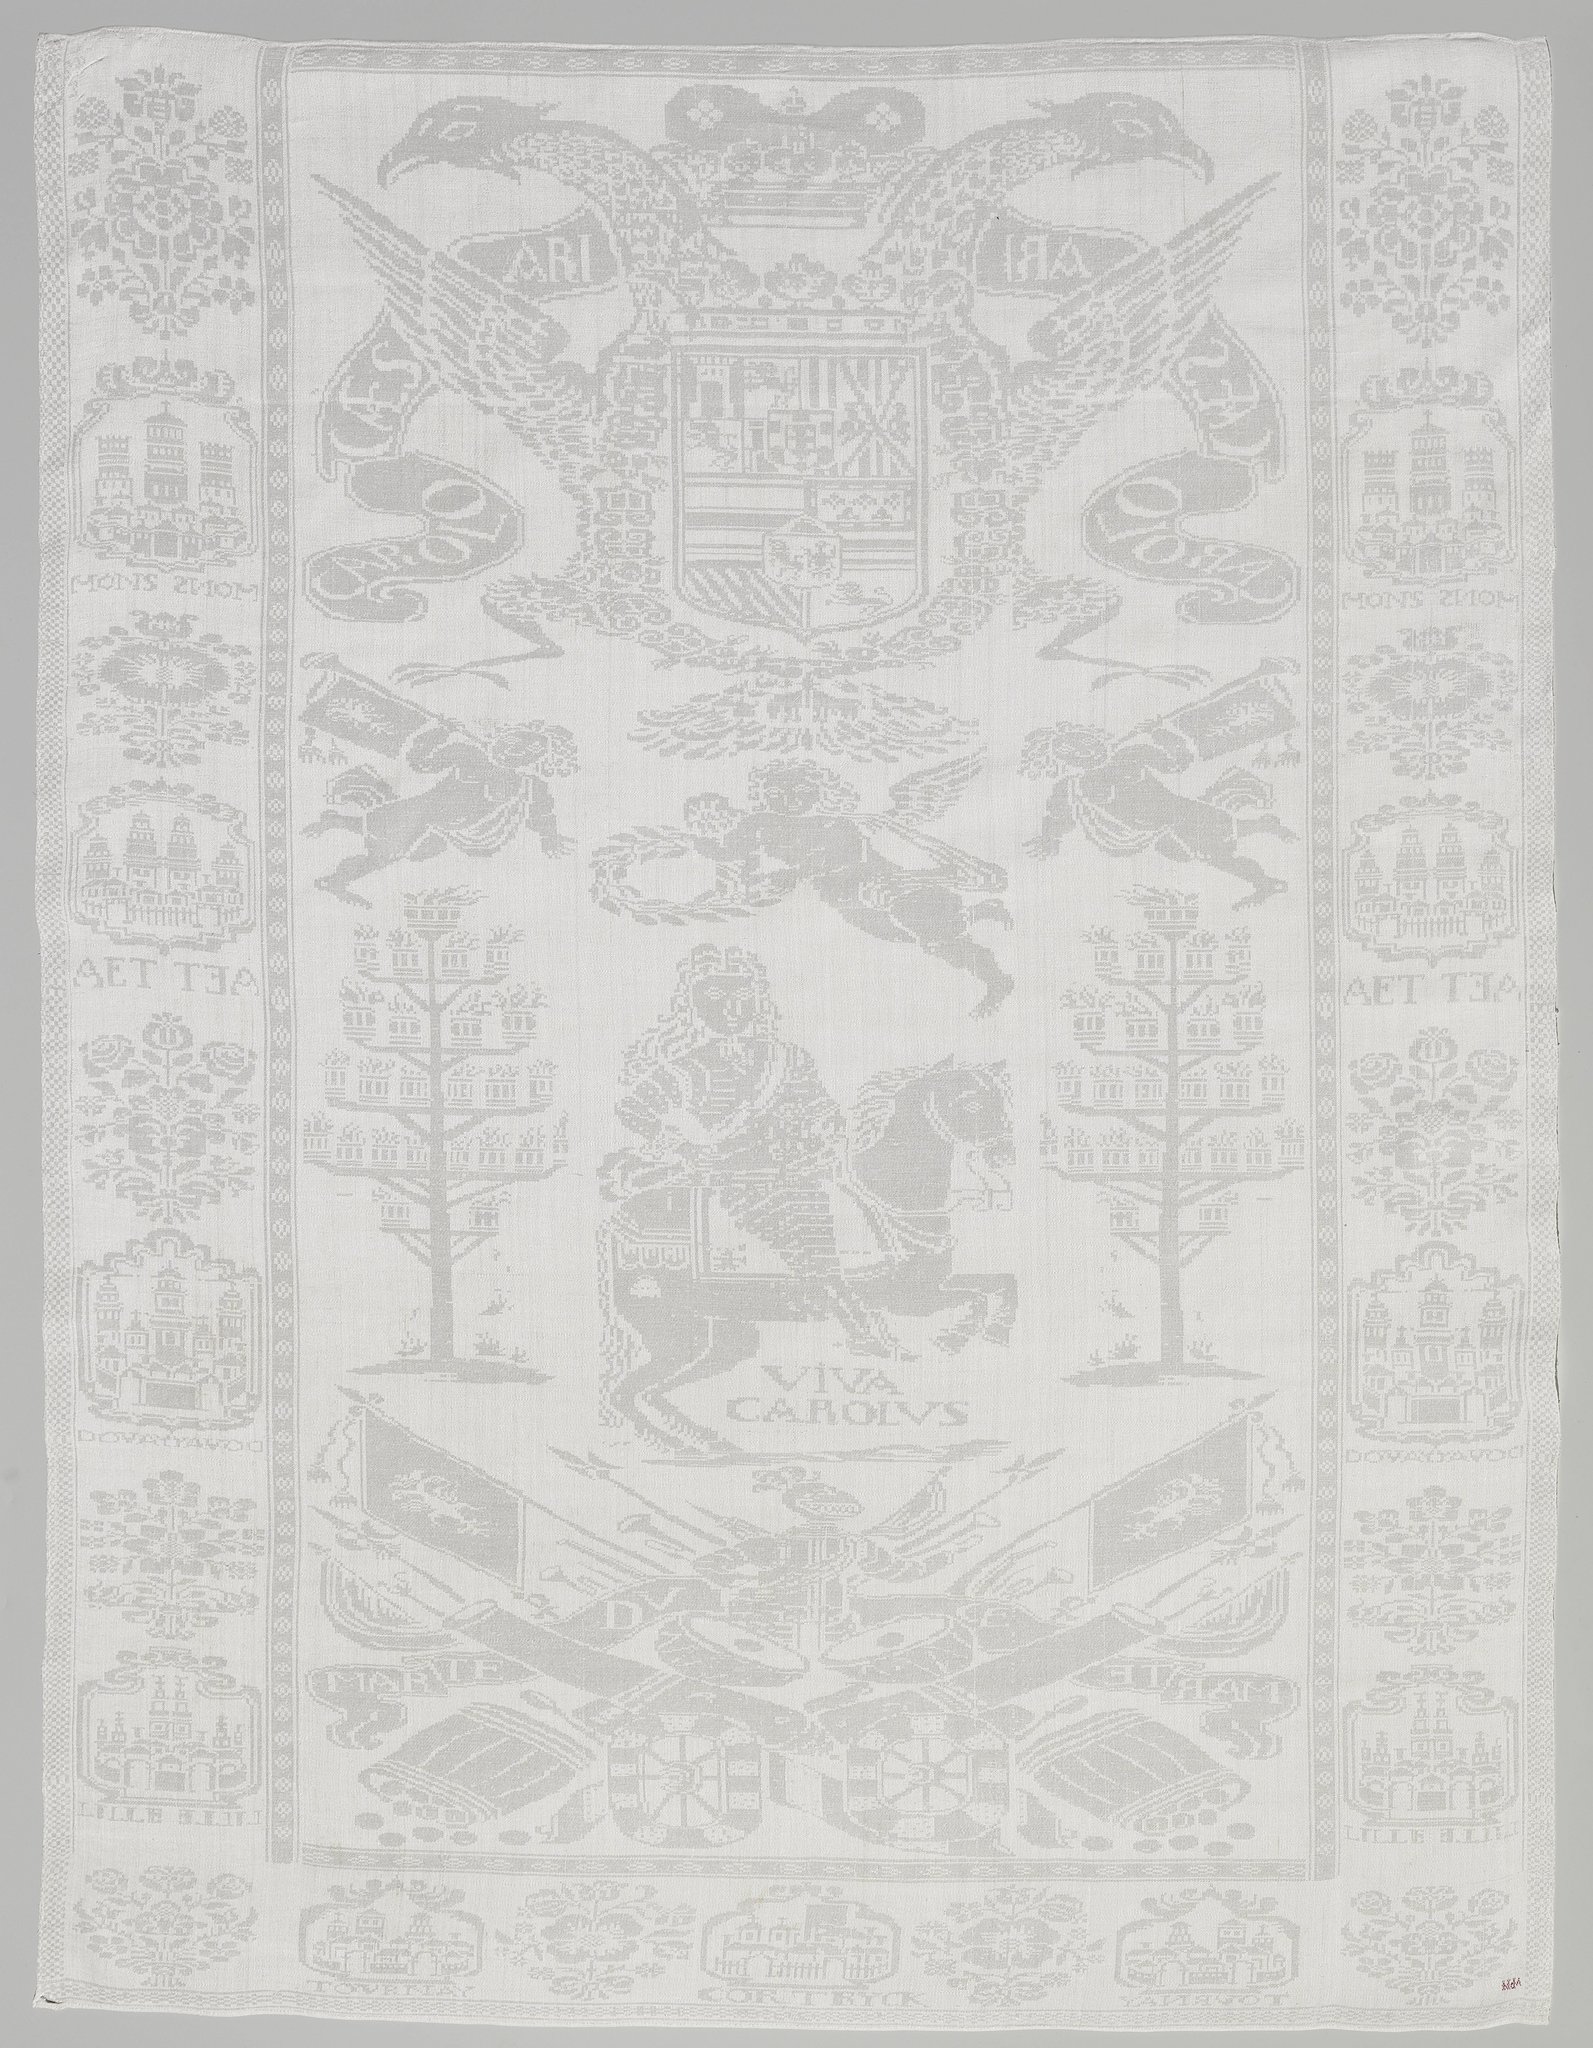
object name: napkin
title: Servet, geweven ter herinnering aan de troonsbestijging van aartshertog Karel van Oostenrijk als keizer van het Heilig Roomse Rijk in 1711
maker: Anonymous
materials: linen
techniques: damask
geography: kortrijk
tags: vienna, charles vi (holy roman emperor)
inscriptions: inscription: ‘CAROLO CAESARI’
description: Servet van linnen, met opschrift CAROLO CAESARI, geweven ter herinnering van de troonsbestijging van aartshertog Karel van Oostenrijk, als keizer Karel VI, keizer van het Heilig Roomse Rijk in 1711.